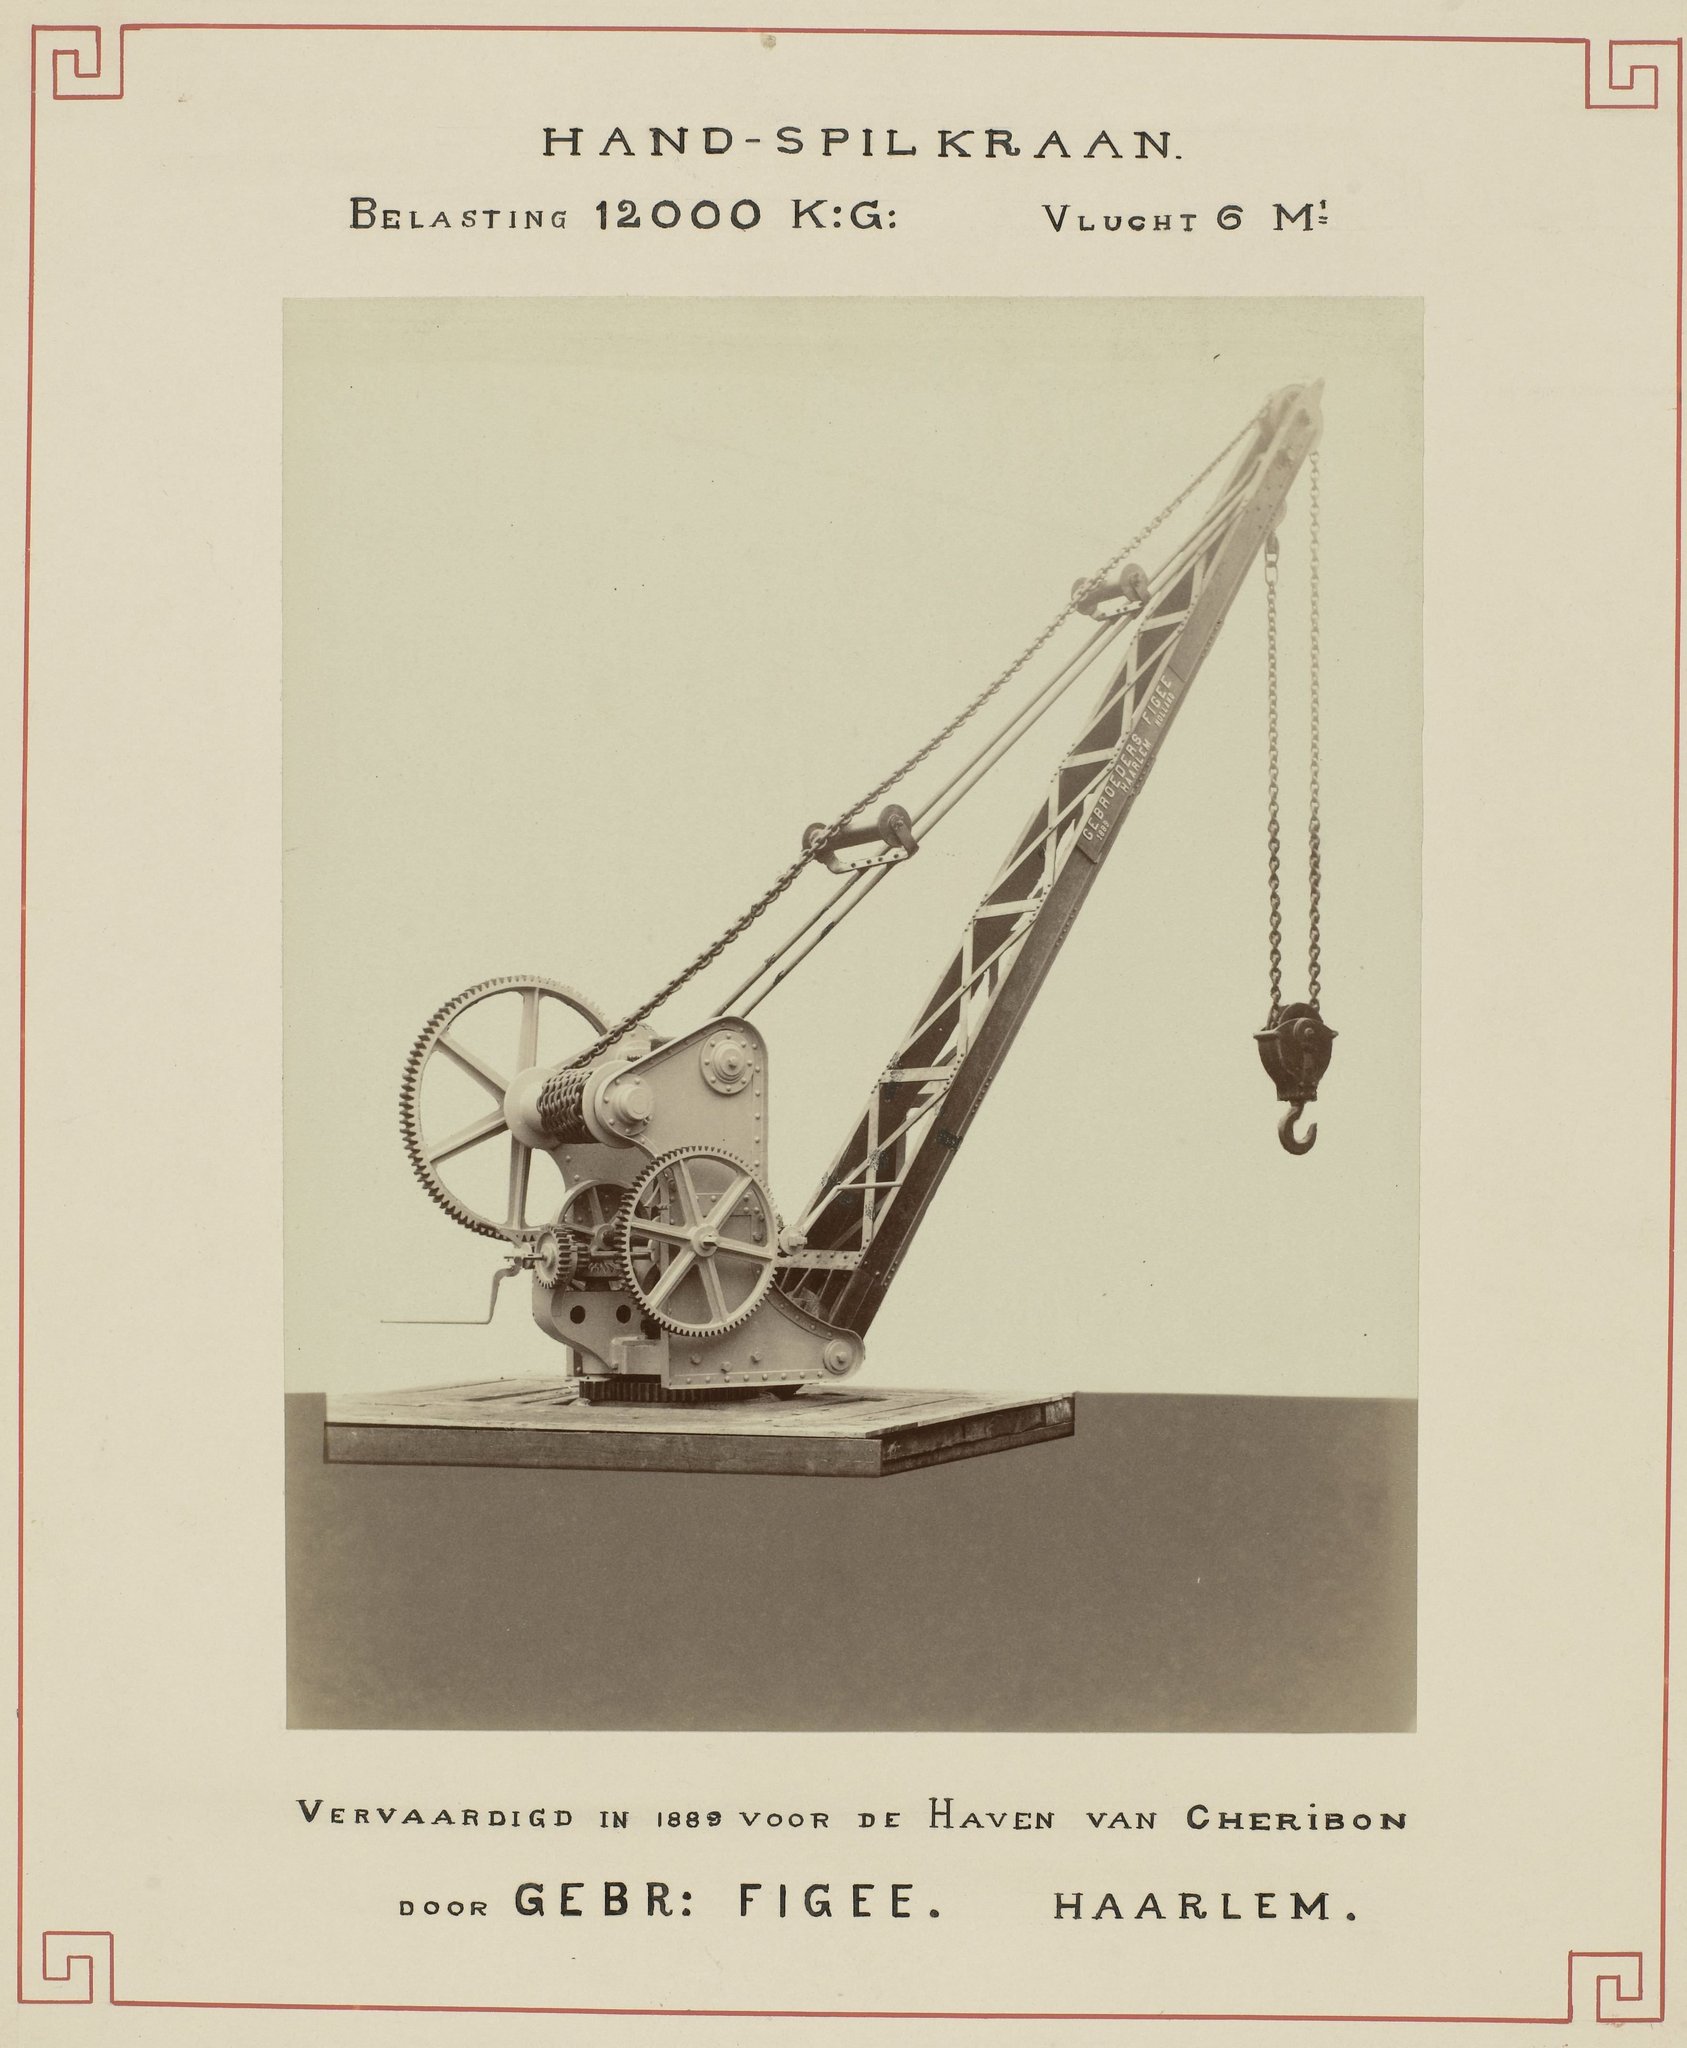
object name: photograph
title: Hand-spilkraan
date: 1885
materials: cardboard, paper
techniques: photography, printing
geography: haarlem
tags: indië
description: Foto van een kraan, op karton geplakt, in rood gelijnd kader met tekst onder en boven waarop opdrachtgever e.d. Vervaardigd voor de Haven van Cheribon. Opschrift; b. en o.: 'Gebr. Figee - Haarlem - Holland'.